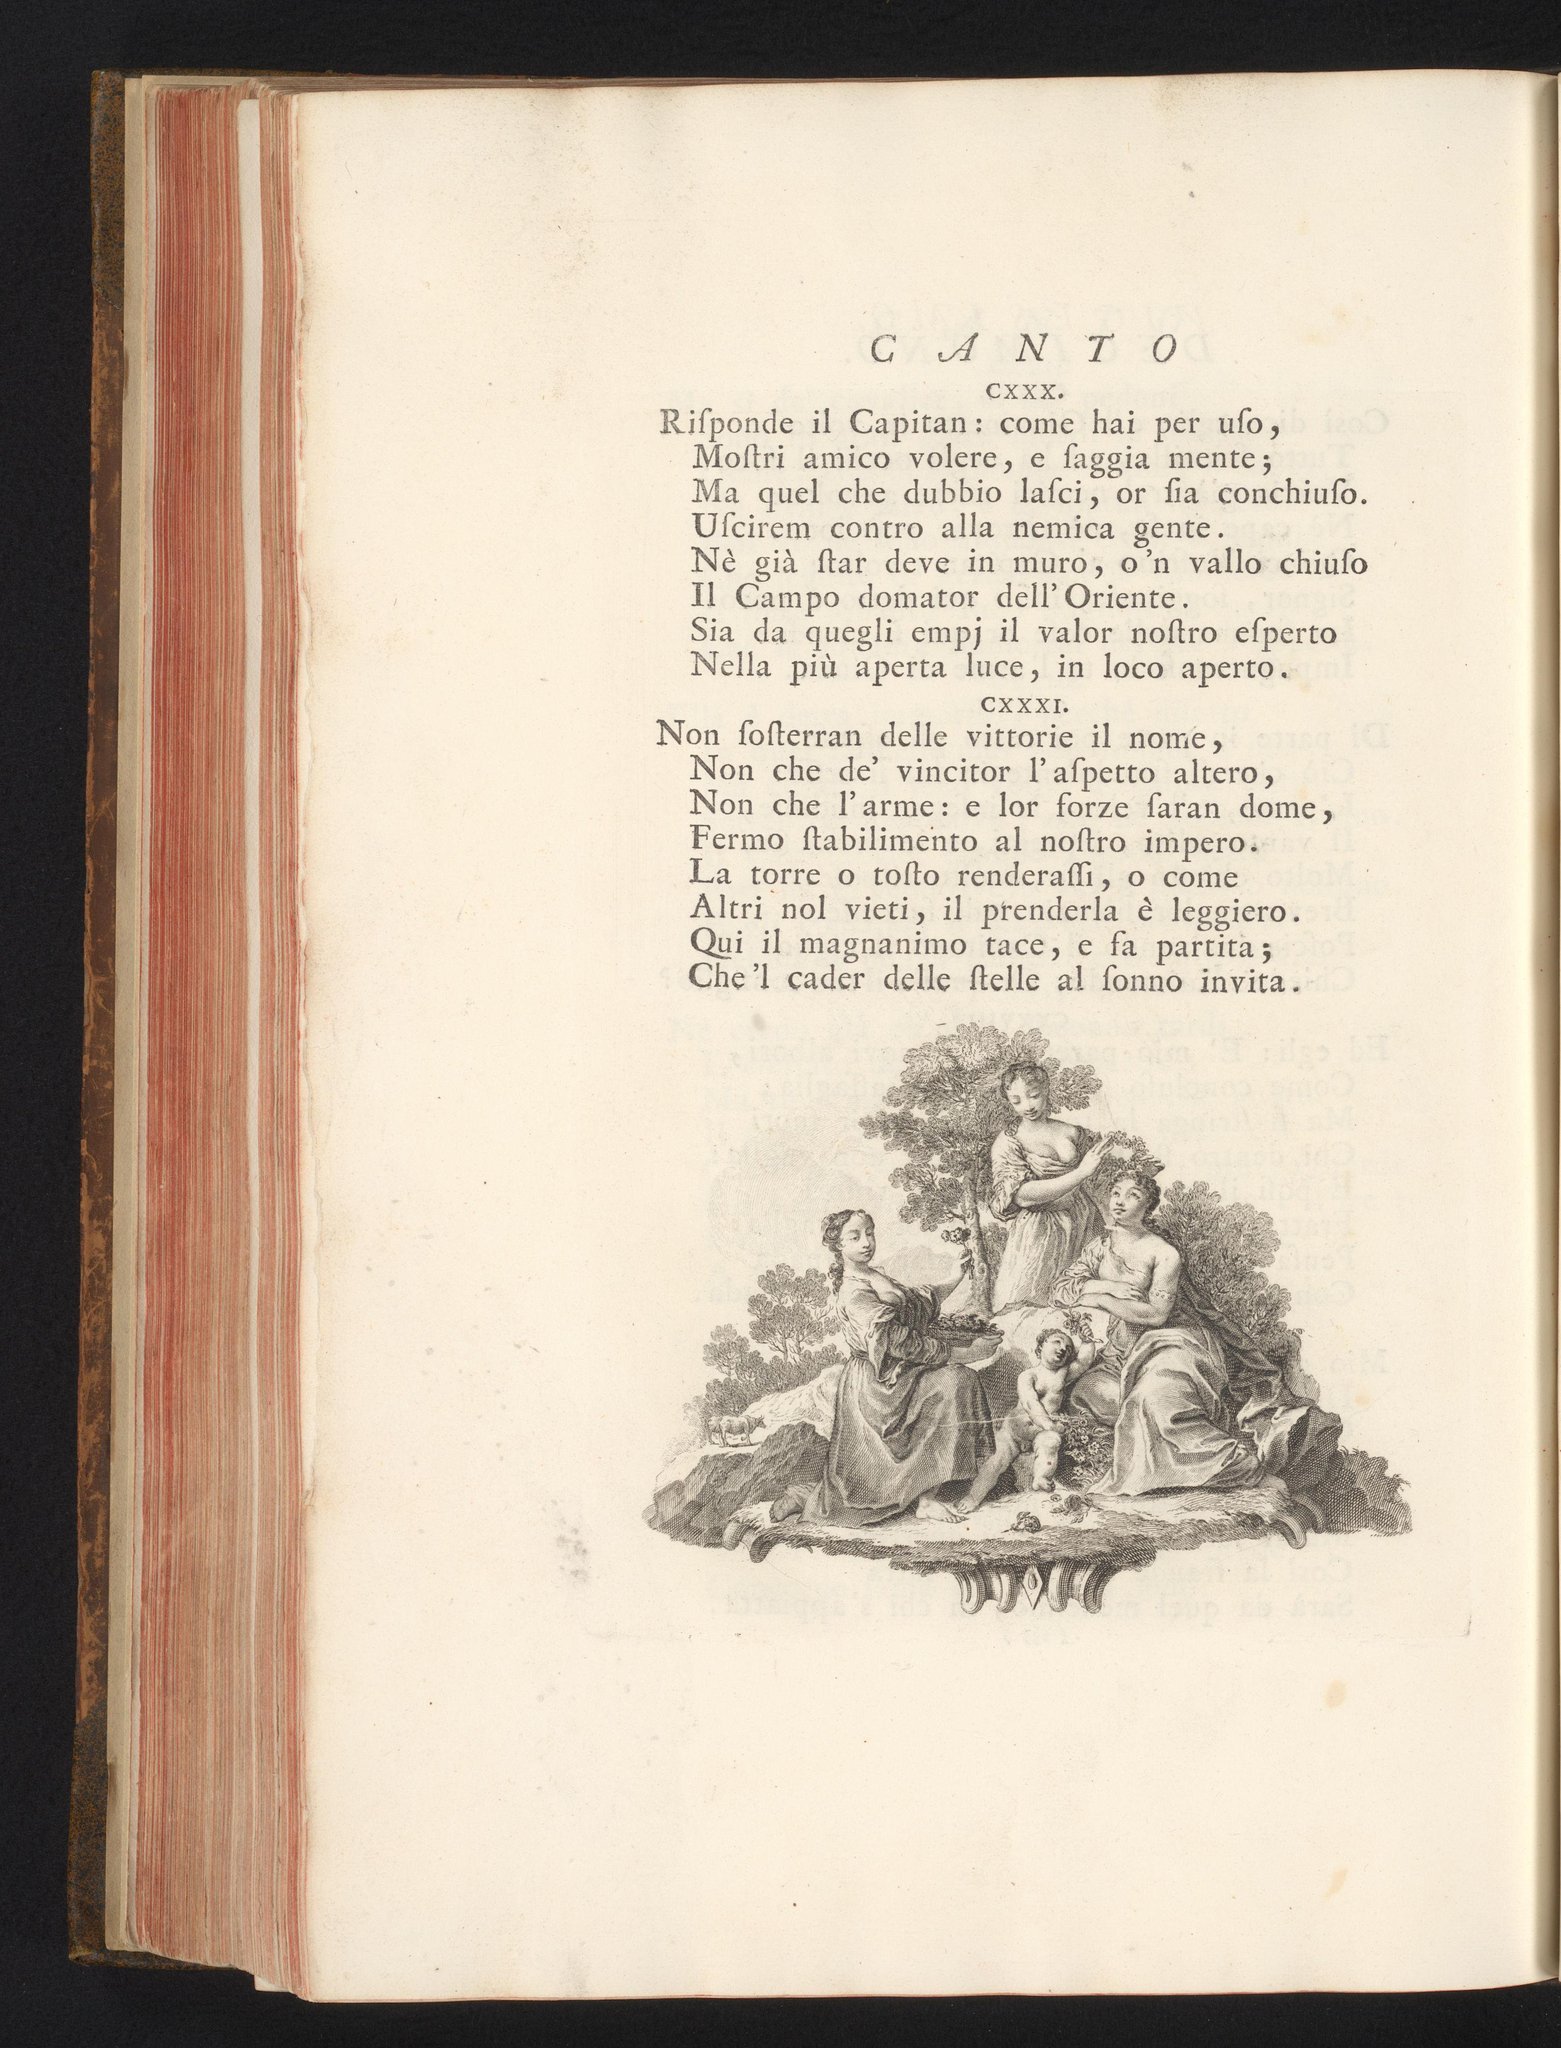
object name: print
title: Drie vrouwen en een putto met bloemen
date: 1745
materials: paper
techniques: etching, letterpress printing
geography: venice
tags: cut flowers; nosegay, bunch of flowers, adult woman, (scenes from) specific works of literature: tasso, gerusalemme liberata, cupids: 'amores', 'amoretti', 'putti'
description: Prent uit: Tasso, Torquato. La Gerusalemme liberata di Torquato Tasso con le figure de Giambatista Piazzetta. Venetië: Giambatista Albrizzi, 1745.